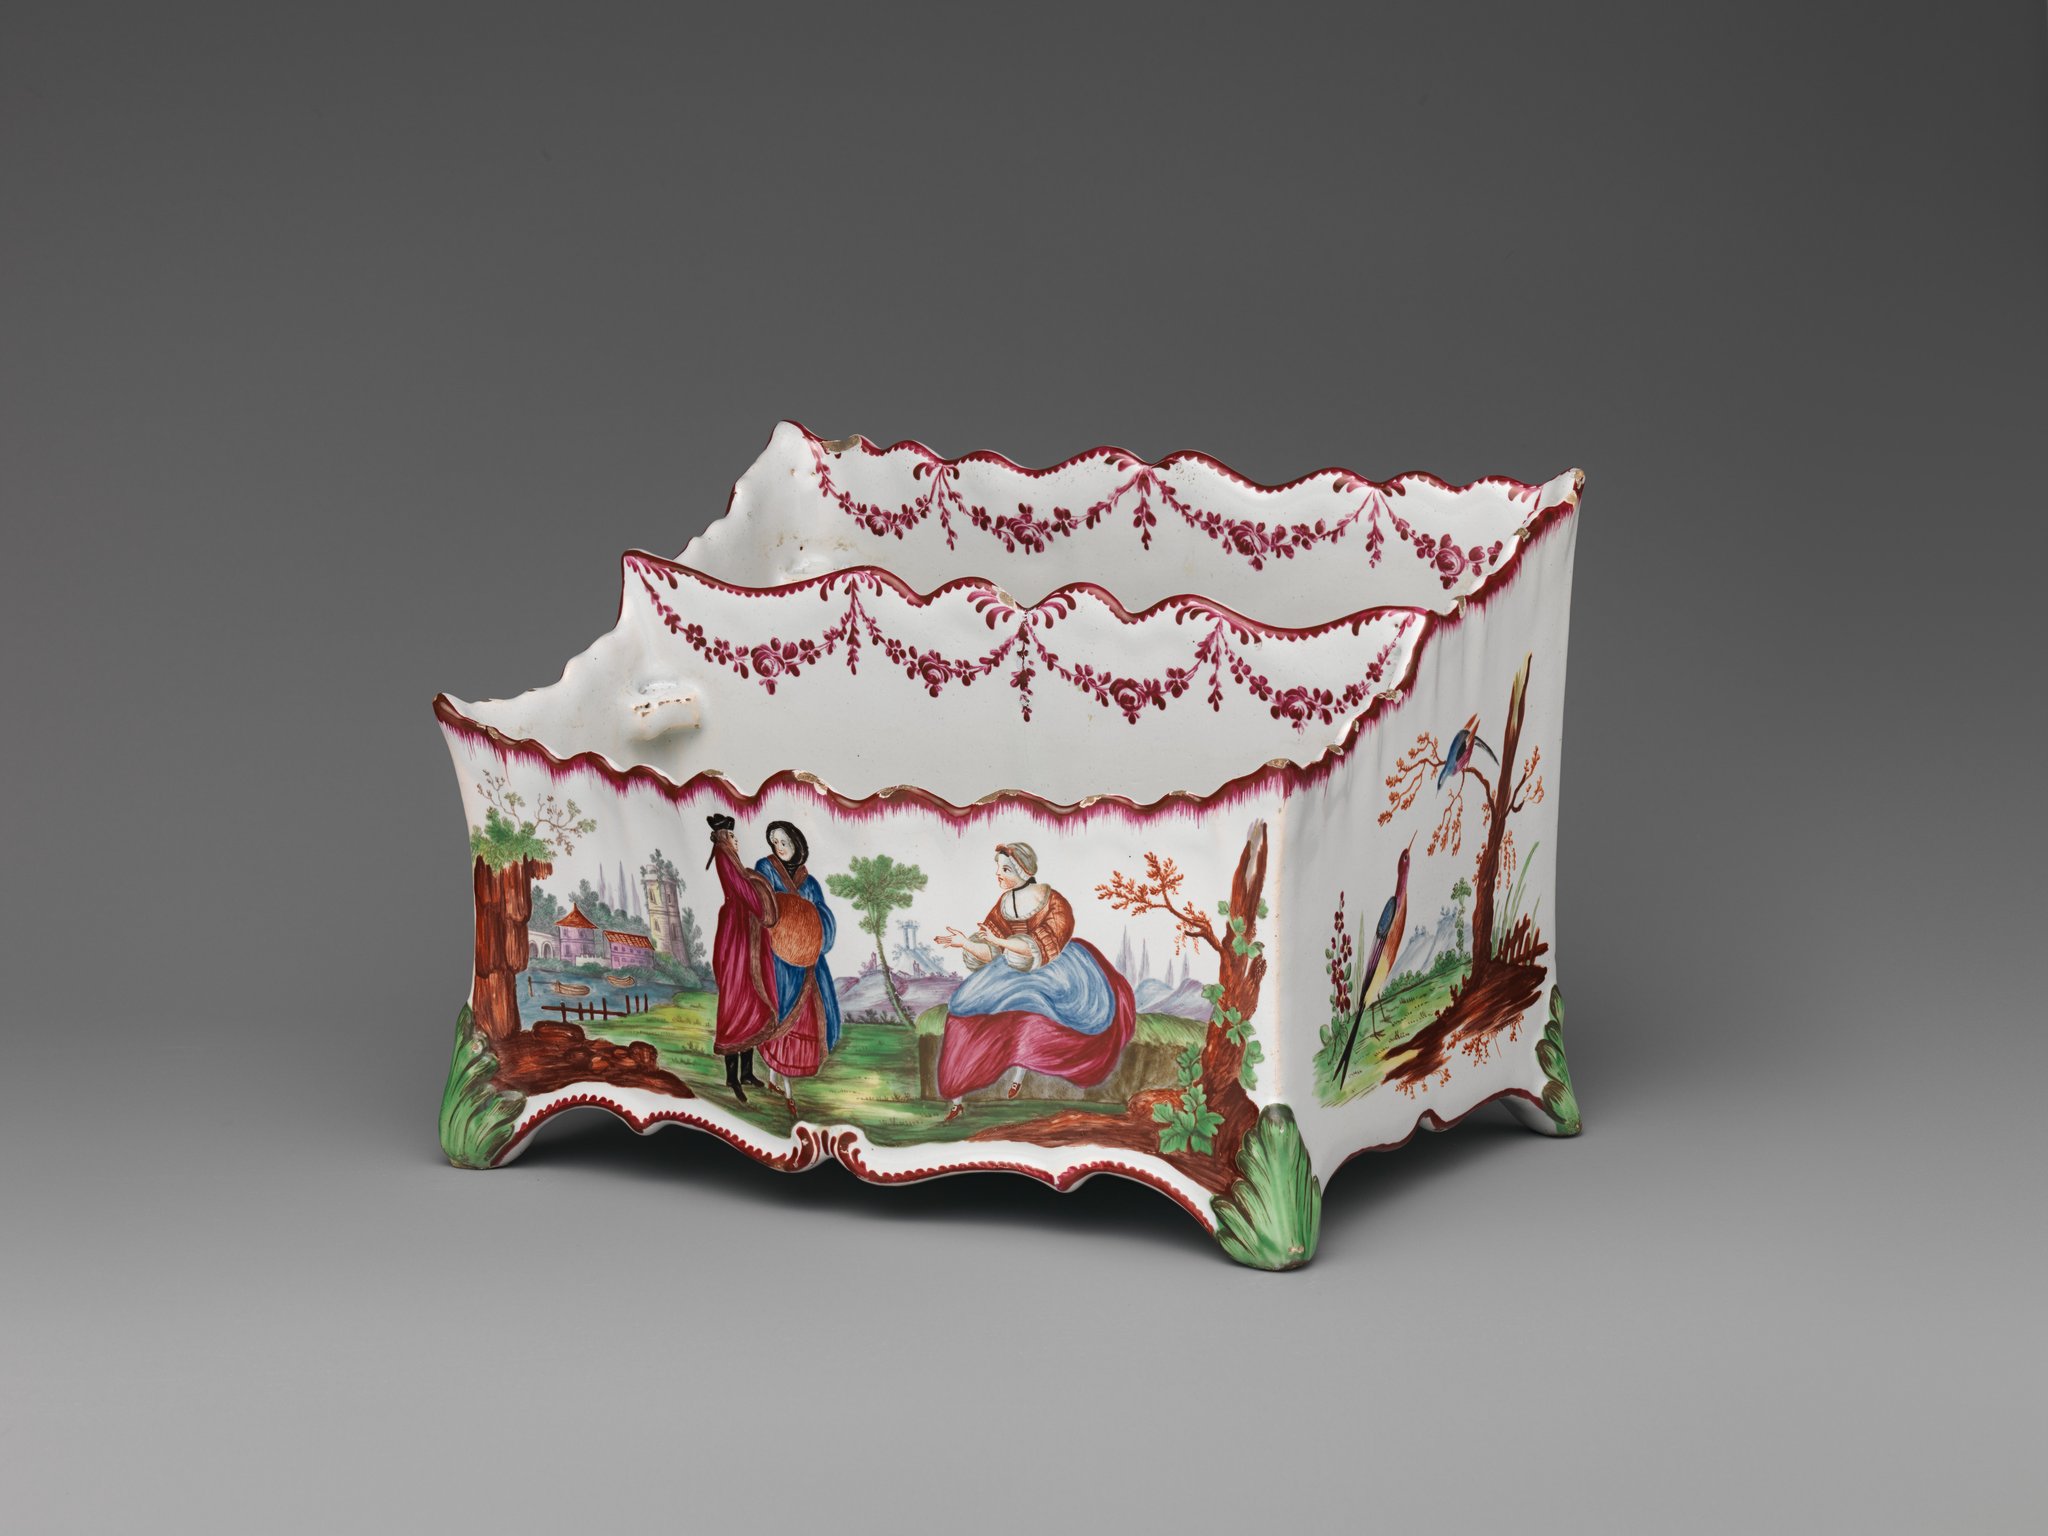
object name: jardinière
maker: levavasseur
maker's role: factory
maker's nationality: french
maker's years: 1715-1825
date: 1770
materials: faience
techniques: glazing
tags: birds,women,trees